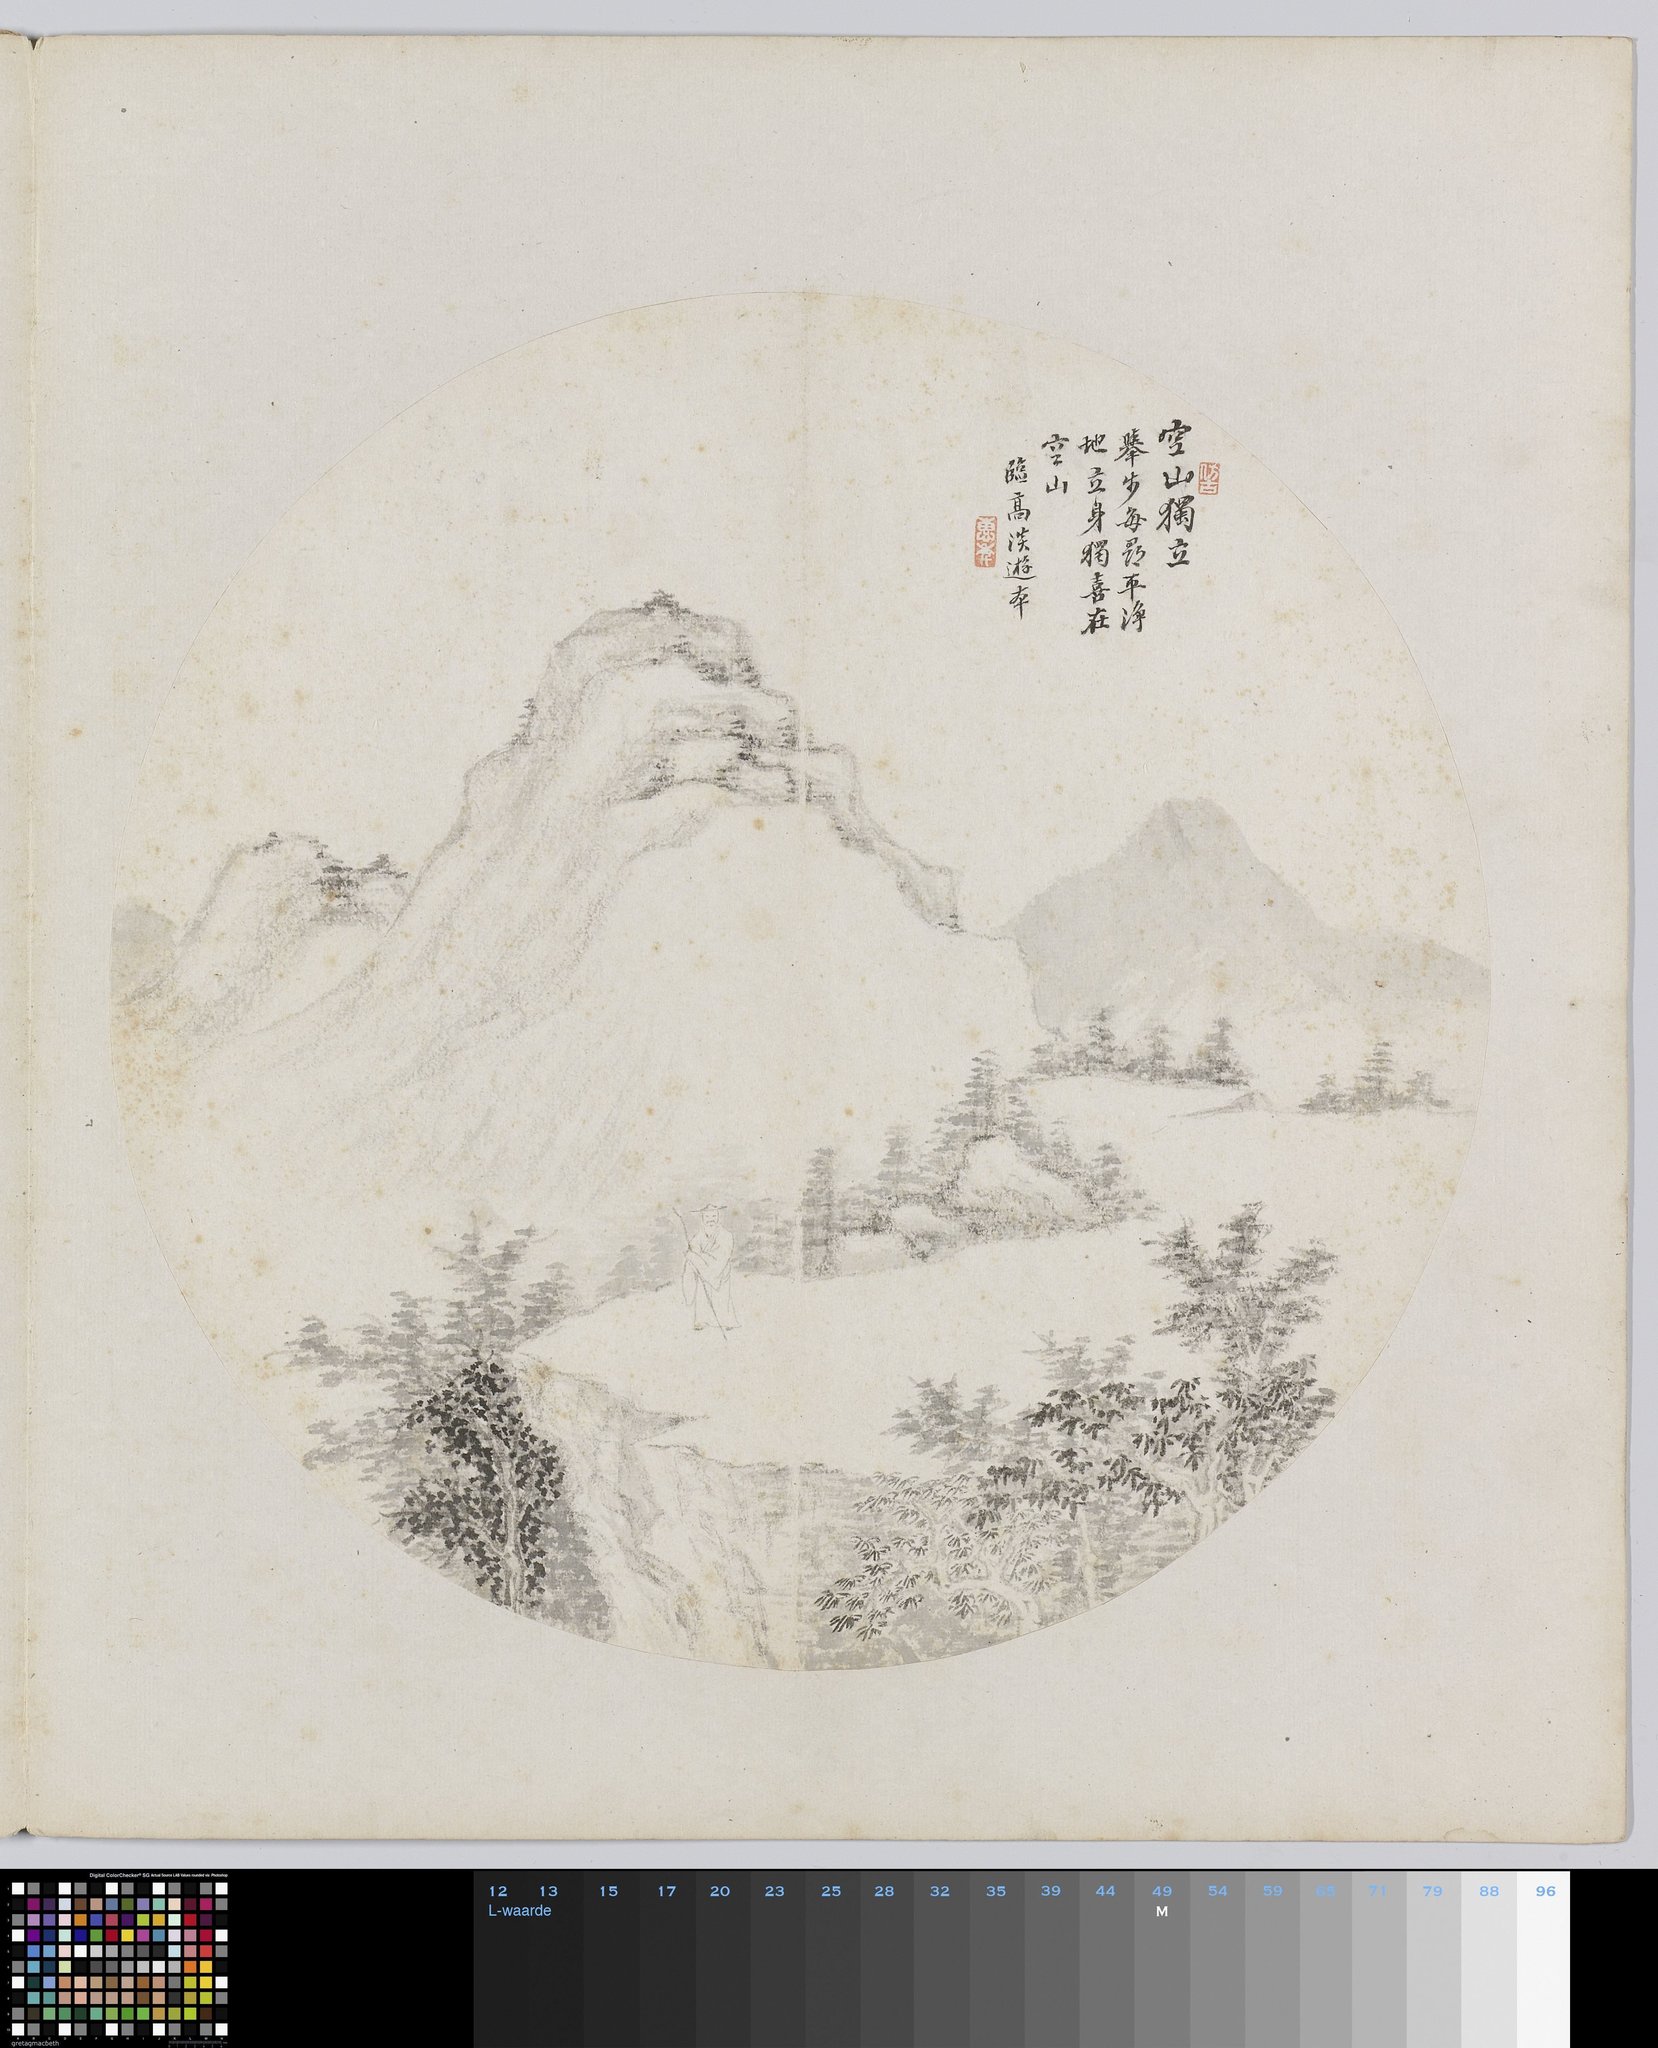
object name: album leaf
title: Albumblad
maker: hui nian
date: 1850-1900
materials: ink, paper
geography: china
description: Albumblad met een landschap. Behoort twee albums met 24 landschappen in de stijl van diverse meesters.